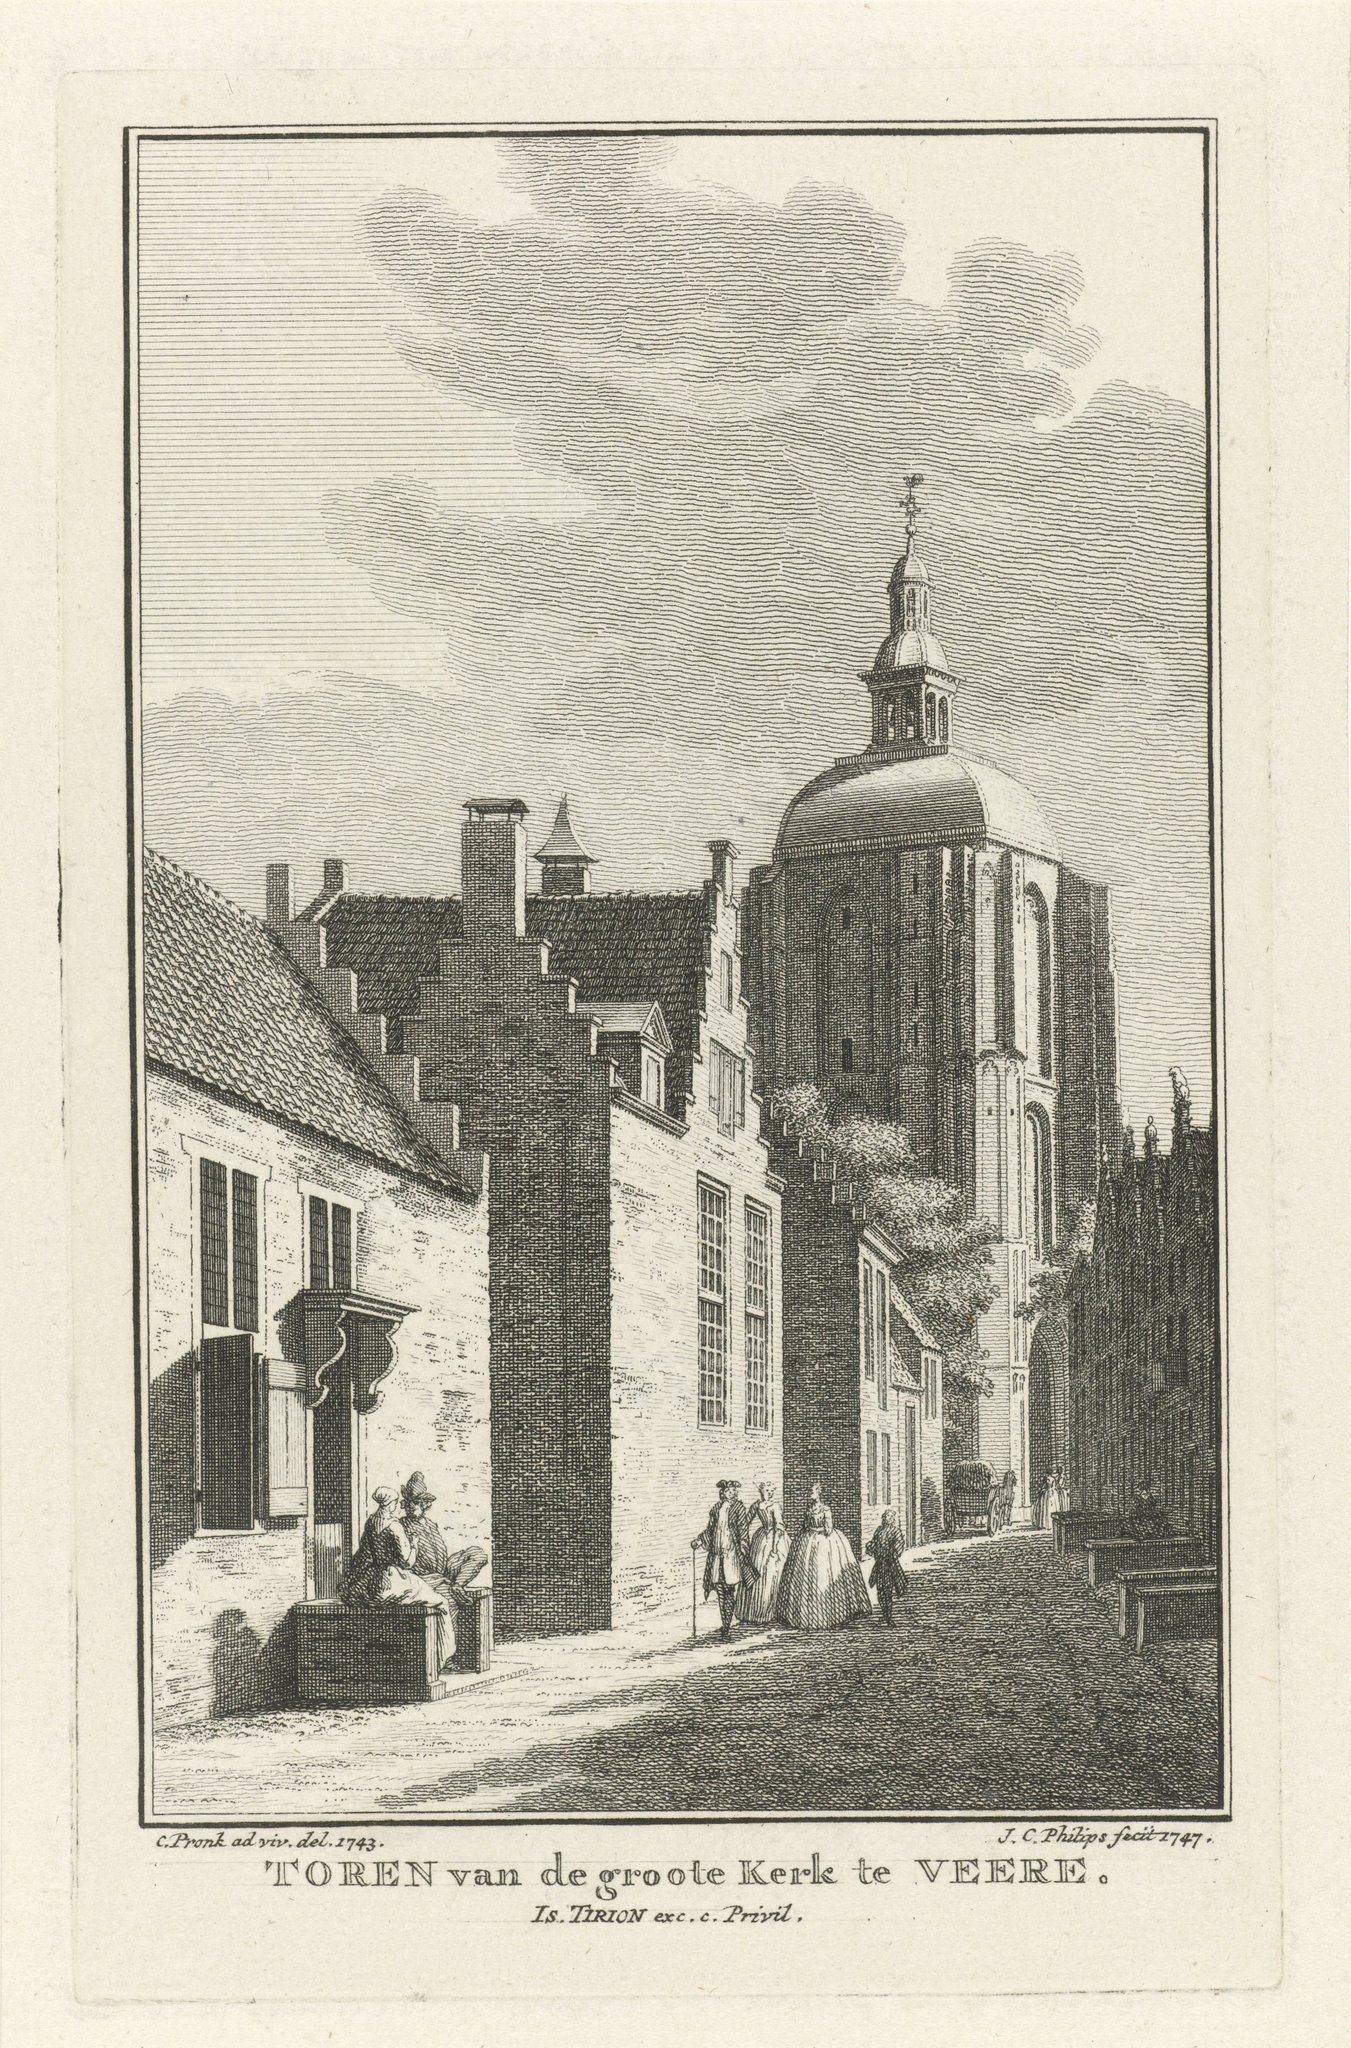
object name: print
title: Toren van de groote Kerk te Veere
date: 1747-1760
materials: paper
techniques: etching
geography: amsterdam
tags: church (exterior), parts of church exterior and annexes: tower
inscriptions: collector's mark: Lugt 2228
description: Gezicht op de toren van de Grote Kerk te Veere, gezien vanuit de Wijngaardstraat, in de situatie omstreeks 1743.